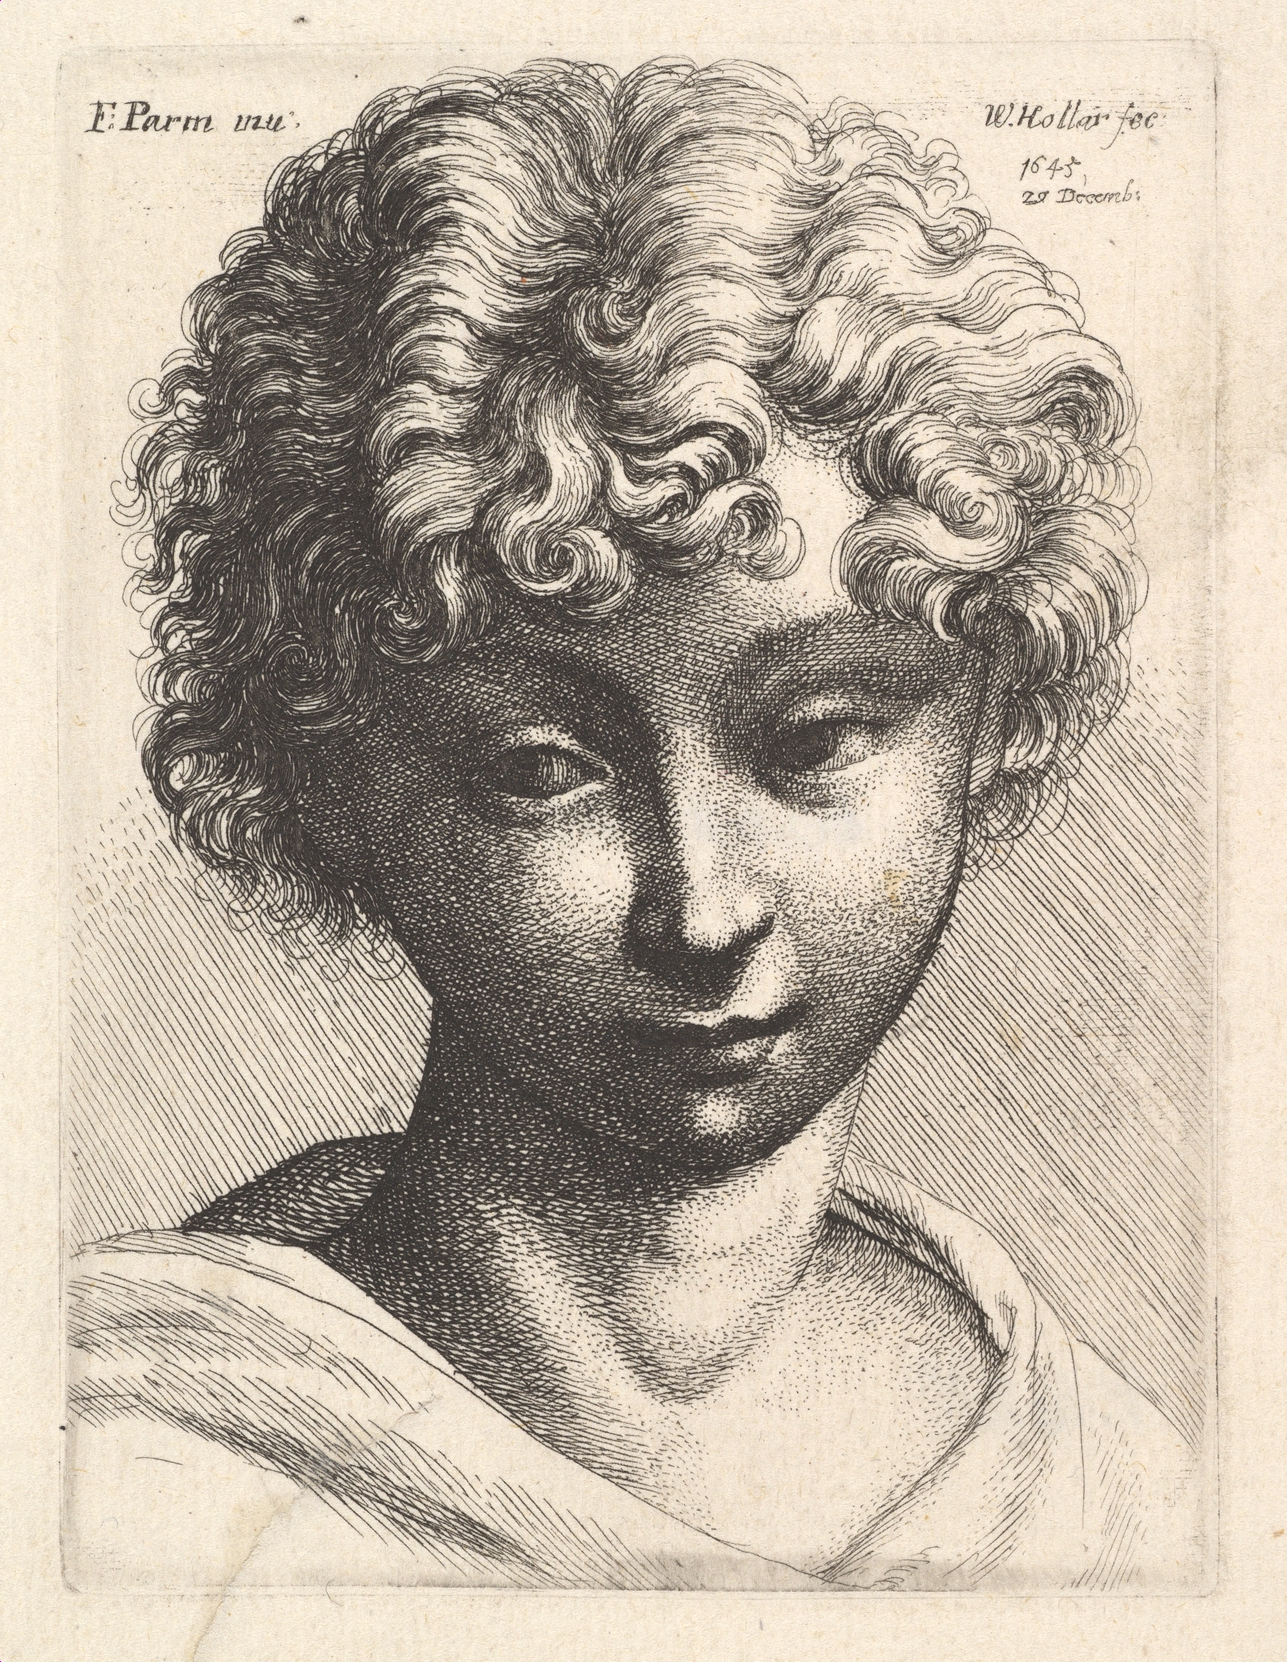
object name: print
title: Head of a young girl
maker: wenceslaus hollar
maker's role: artist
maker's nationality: bohemian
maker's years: 1607-1677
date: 1645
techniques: etching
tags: heads,girls,portraits